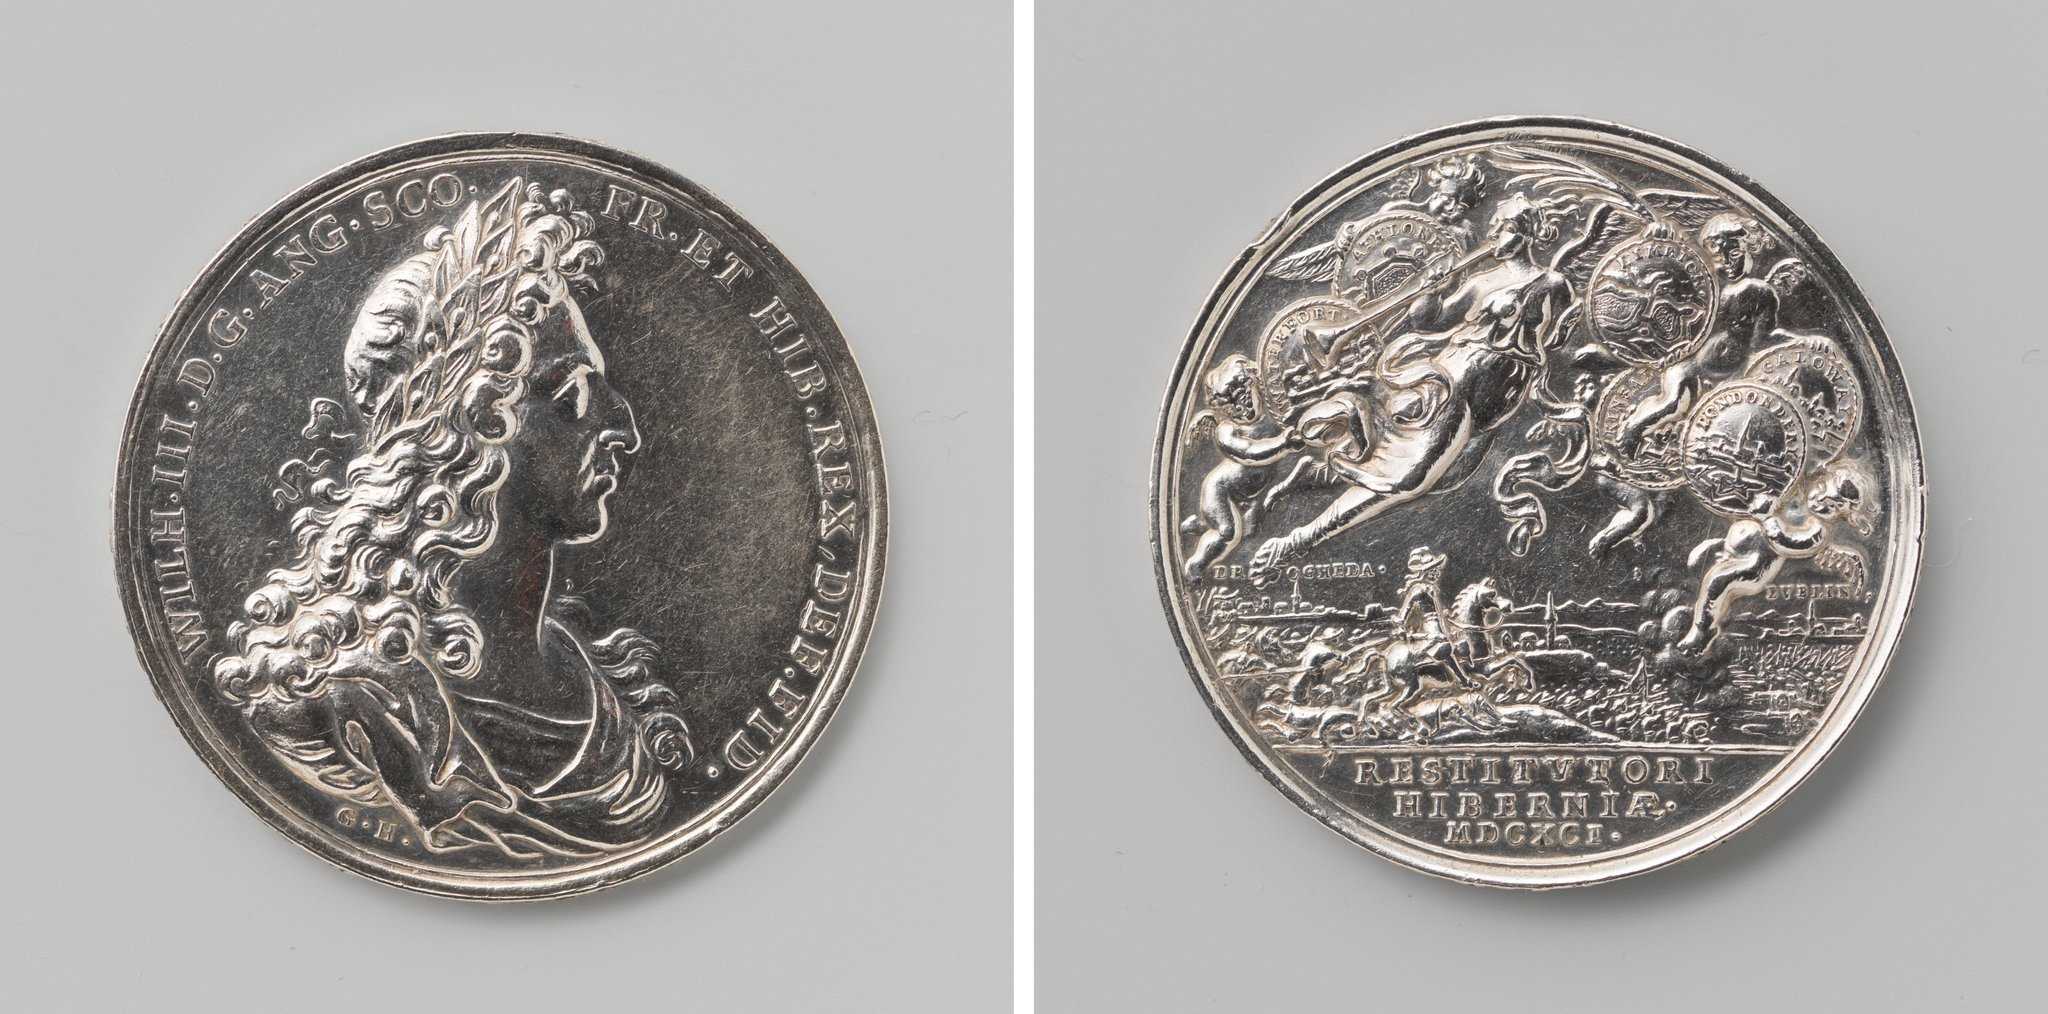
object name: history medal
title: Onderwerping van Ierland door Willem III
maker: georg hautsch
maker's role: medailleur, muntmaker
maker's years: 1679-1745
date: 1691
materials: silver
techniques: striking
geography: nuremberg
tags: the hague, william iii (prince of orange and king of england, scotland, and ireland)